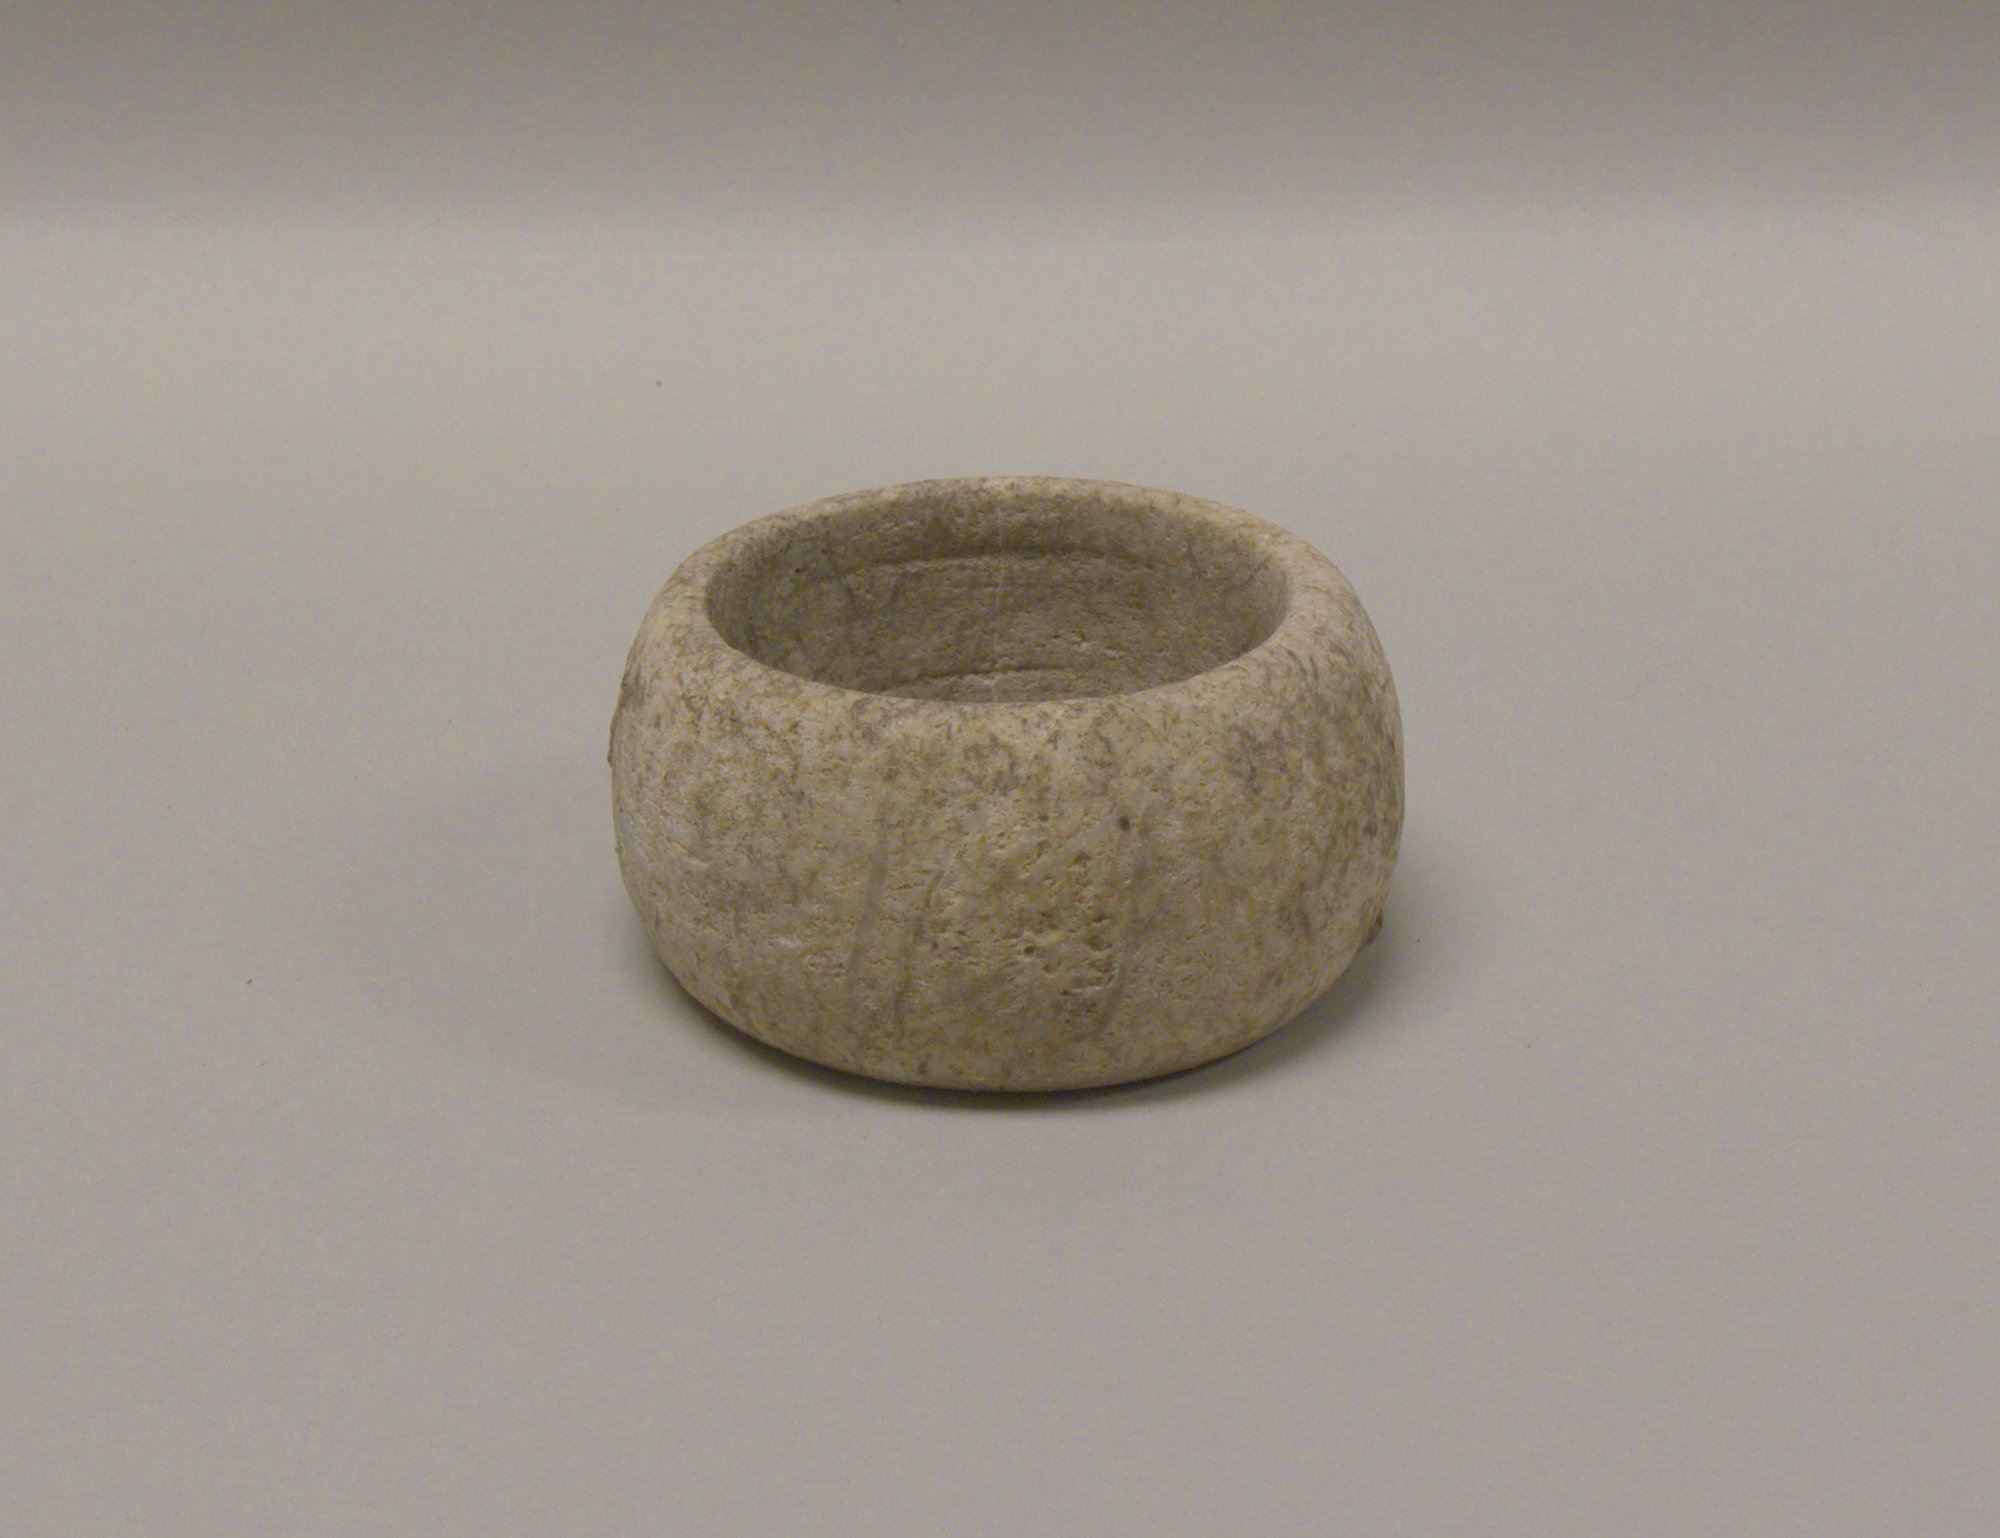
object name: bracelet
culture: thai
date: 1000-300 BCE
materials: stone